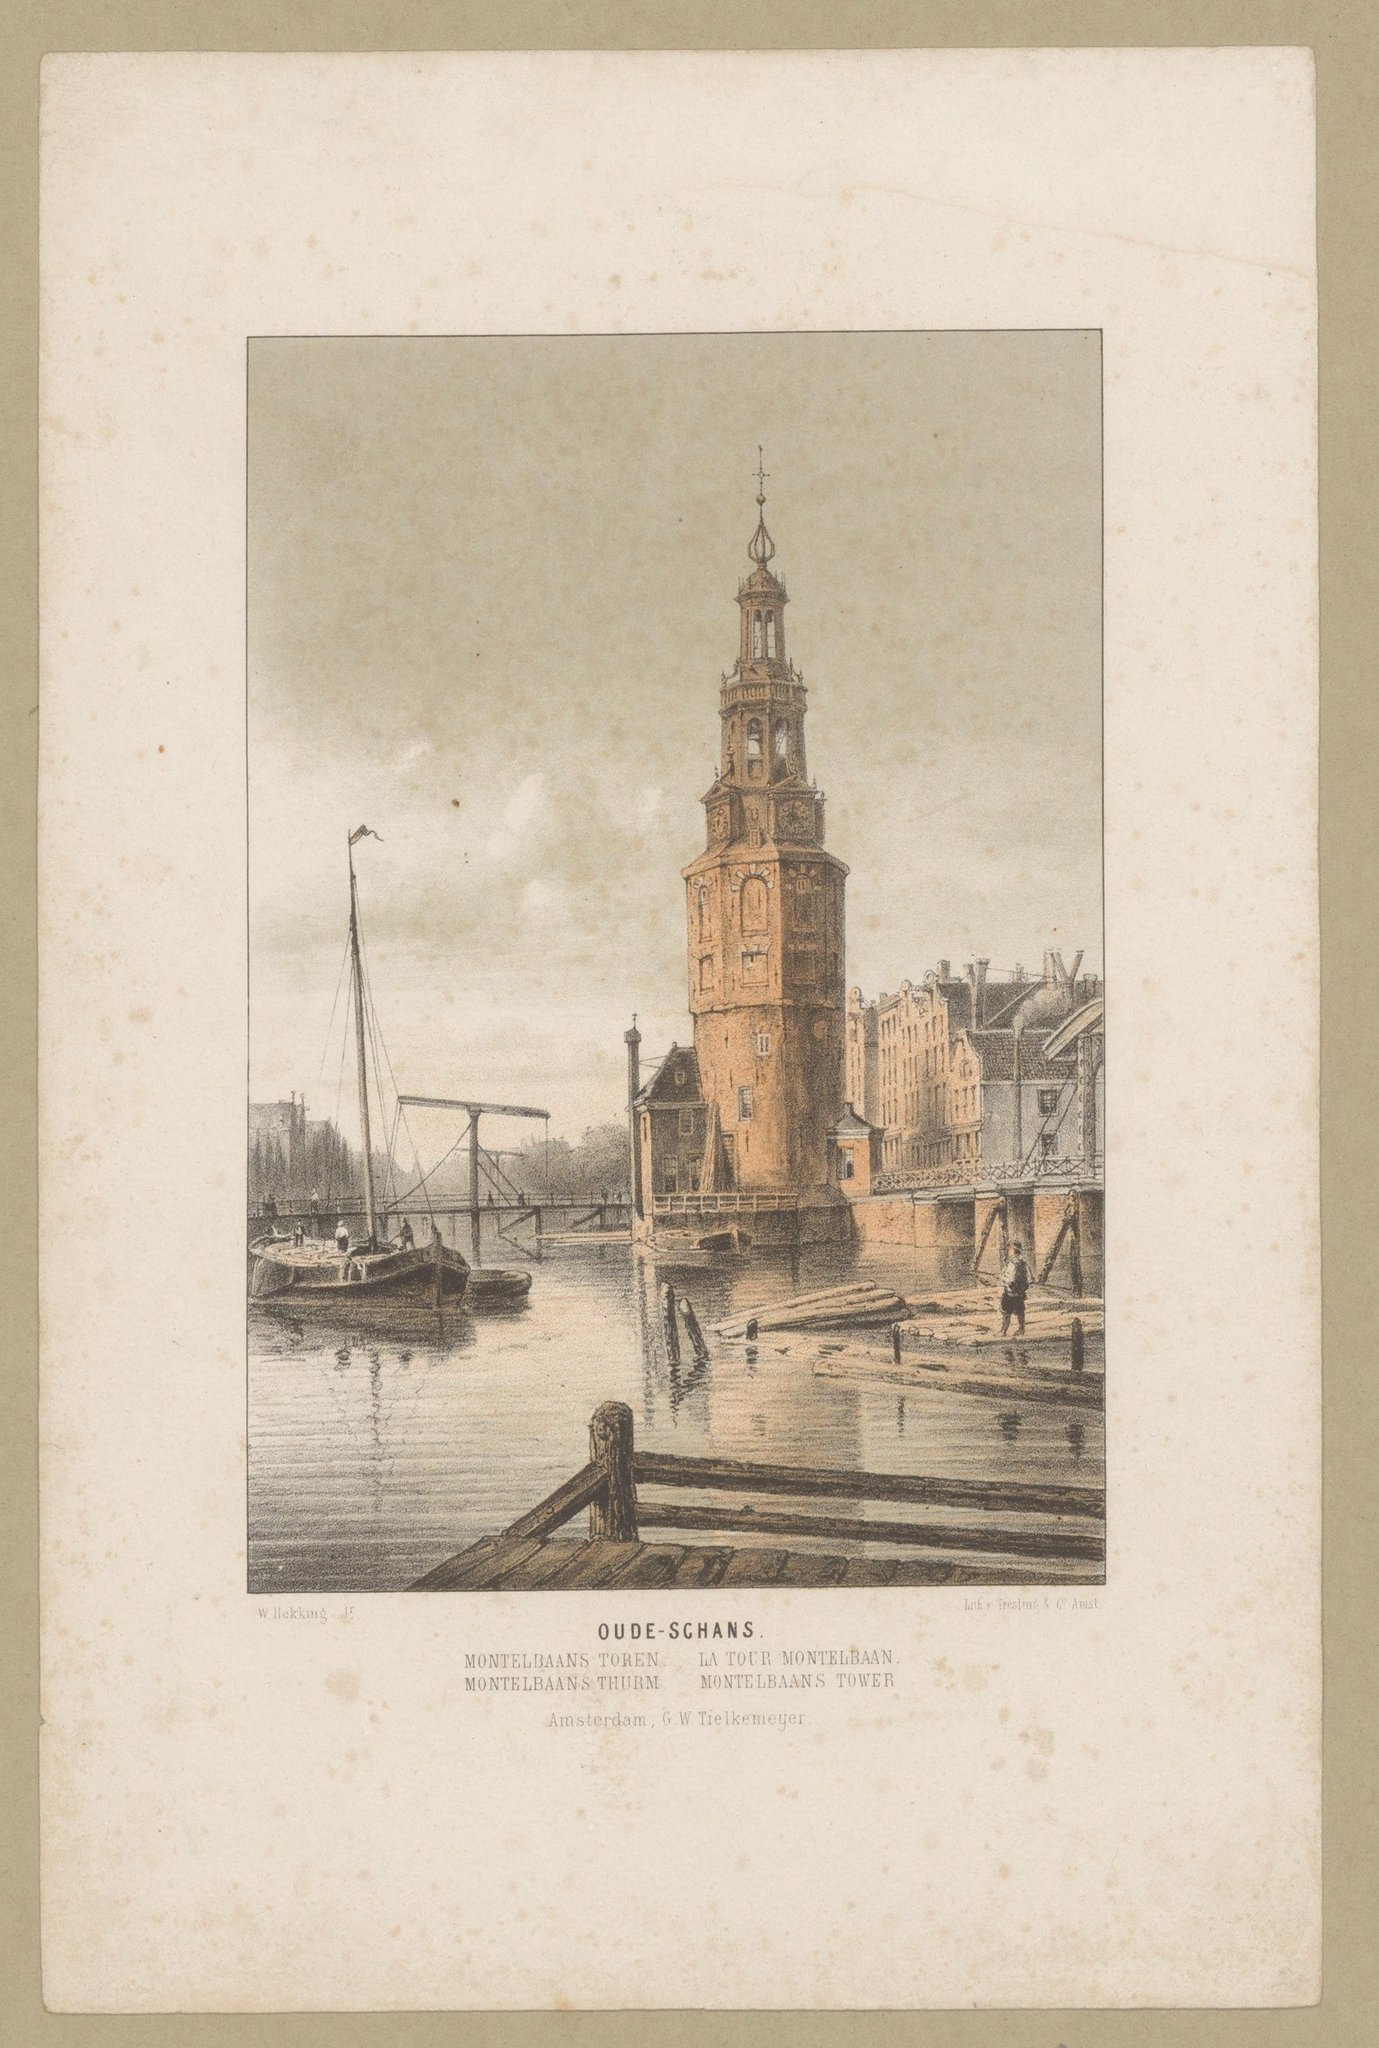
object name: print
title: Montelbaans Toren / La Tour Montelbaan / Montelbaans Thurm / Montelbaans Tower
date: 1861-1862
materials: paper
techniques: lithograph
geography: netherlands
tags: bridge in city across river, canal, etc. (+ city(-scape) with figures, staffage), sailing-ship, sailing-boat, tower, clock tower ~ monumental adornment, pier, quay, wharf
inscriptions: collector's mark: Lugt 1641b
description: Prent uit: Witkamp, Pieter Harmen. Amsterdam in Schetsen. Amsterdam: George Willem Tielkemeijer, 1861. Of uit latere editie van 1862.